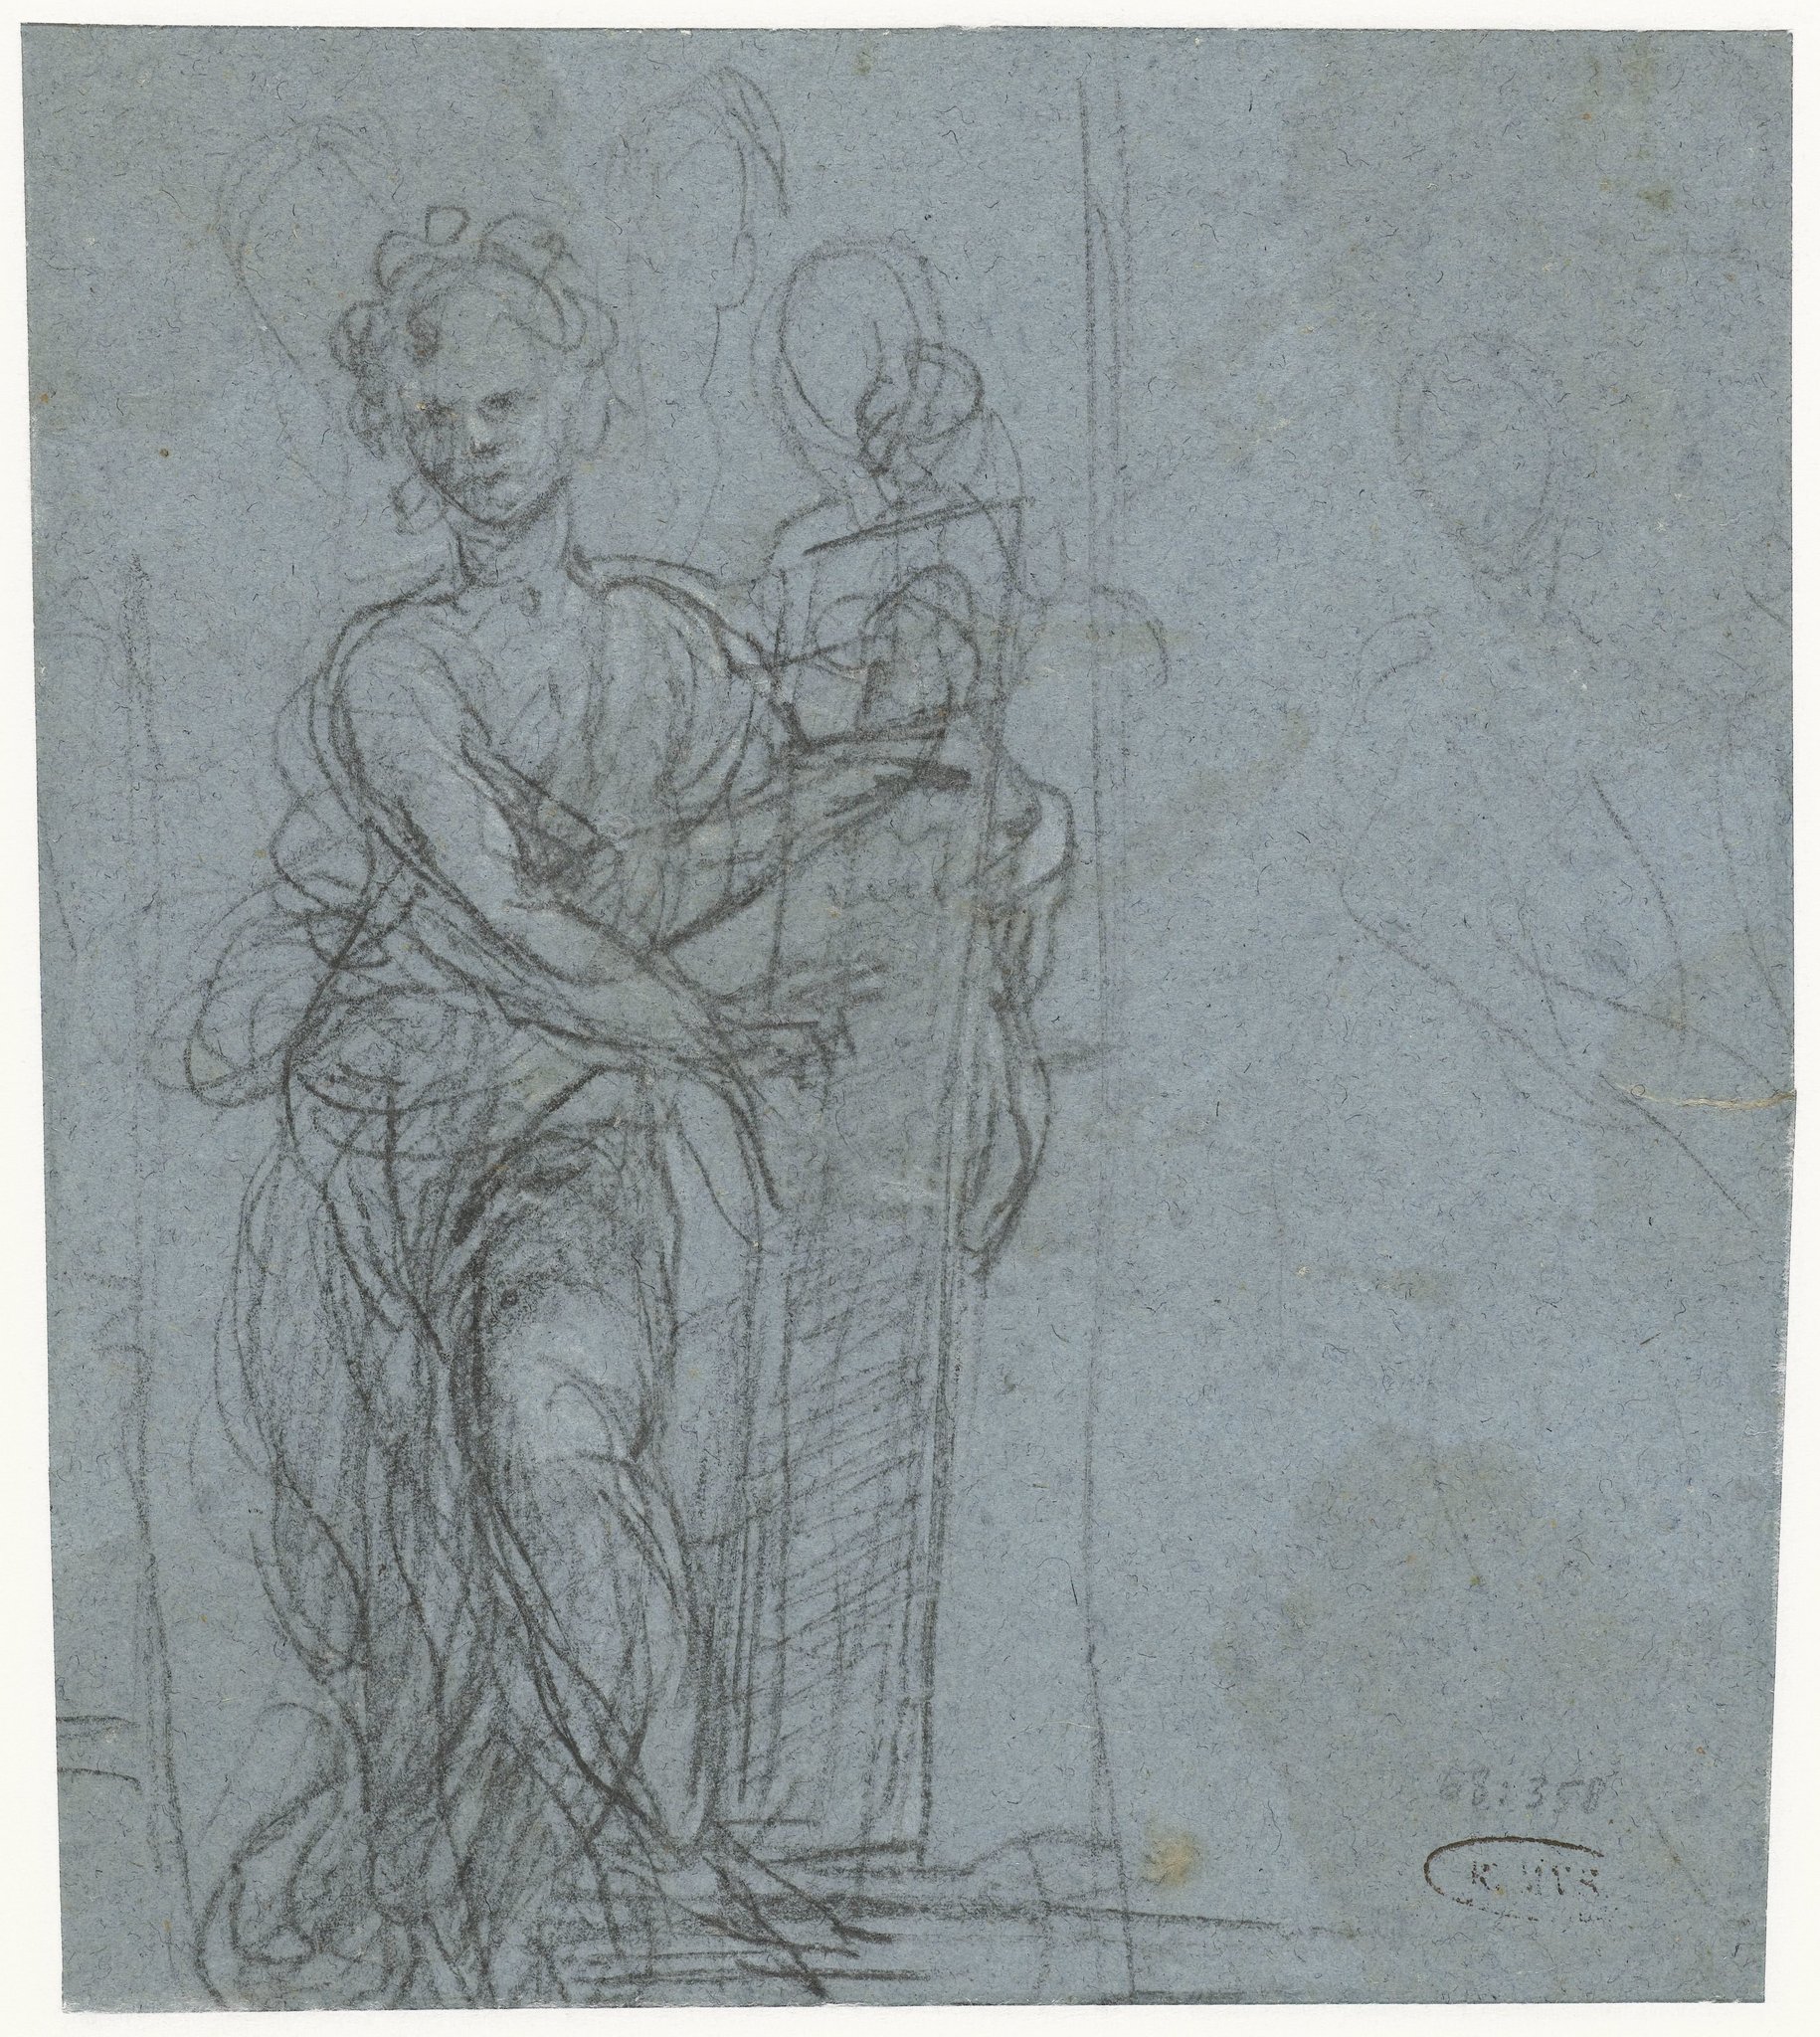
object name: drawing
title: Vrouw met een groot tablet of schild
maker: flaminio torri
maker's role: draughtsman, print maker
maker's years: 1621-1661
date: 1631-1661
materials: paper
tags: standing figure - aa - female human figure